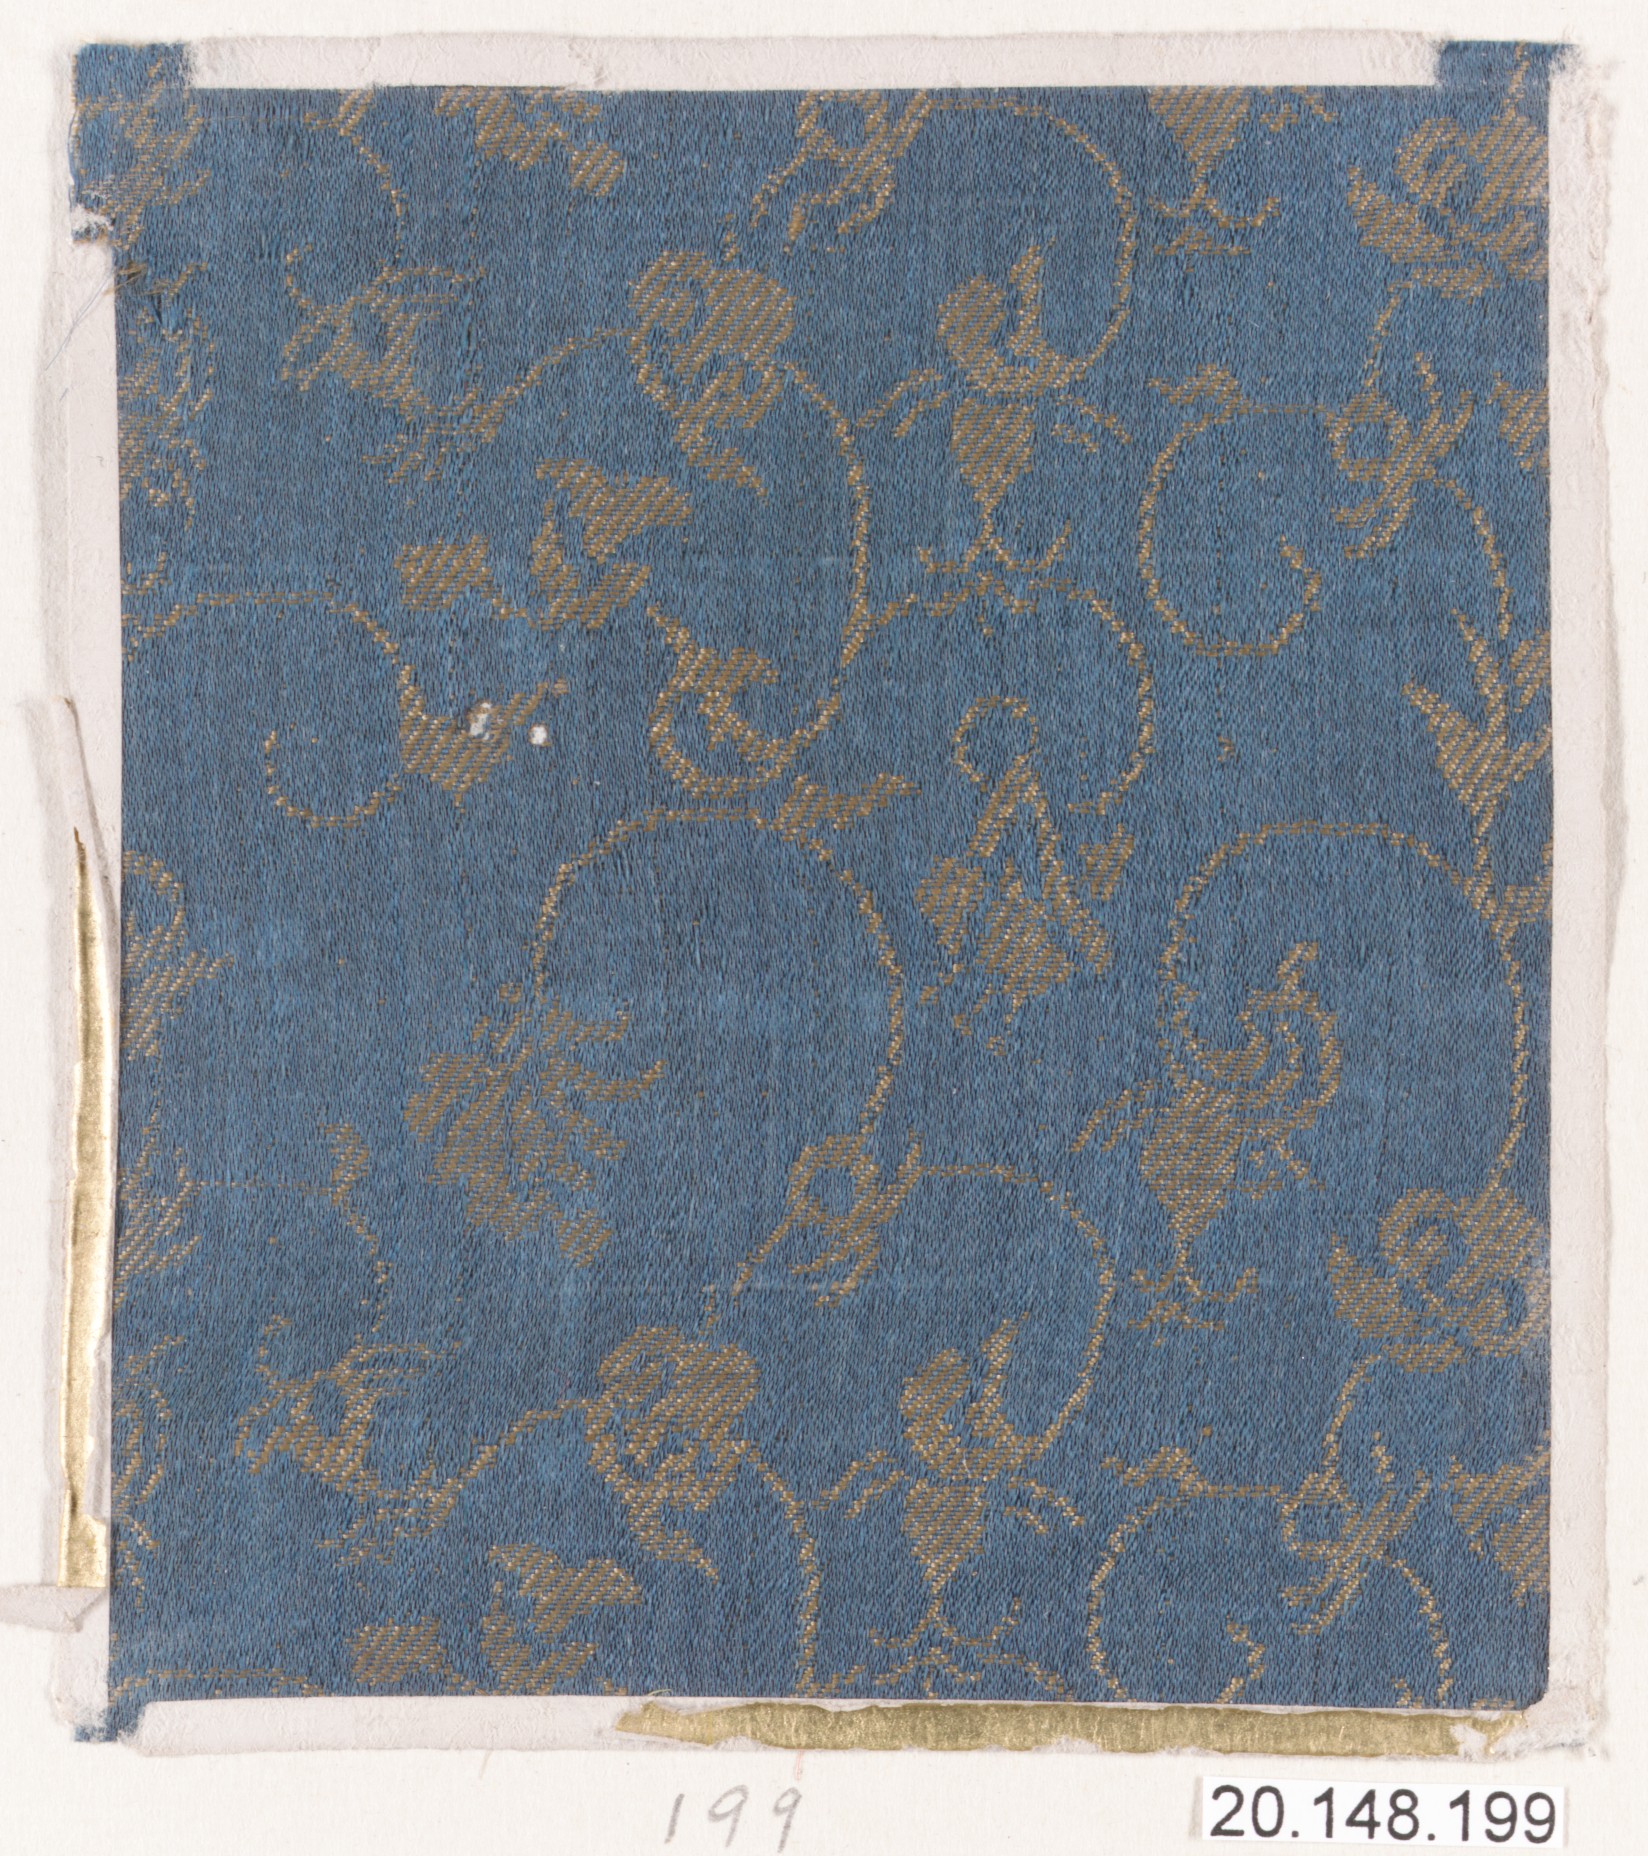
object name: piece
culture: japanese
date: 1701-1800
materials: silk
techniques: compound weave